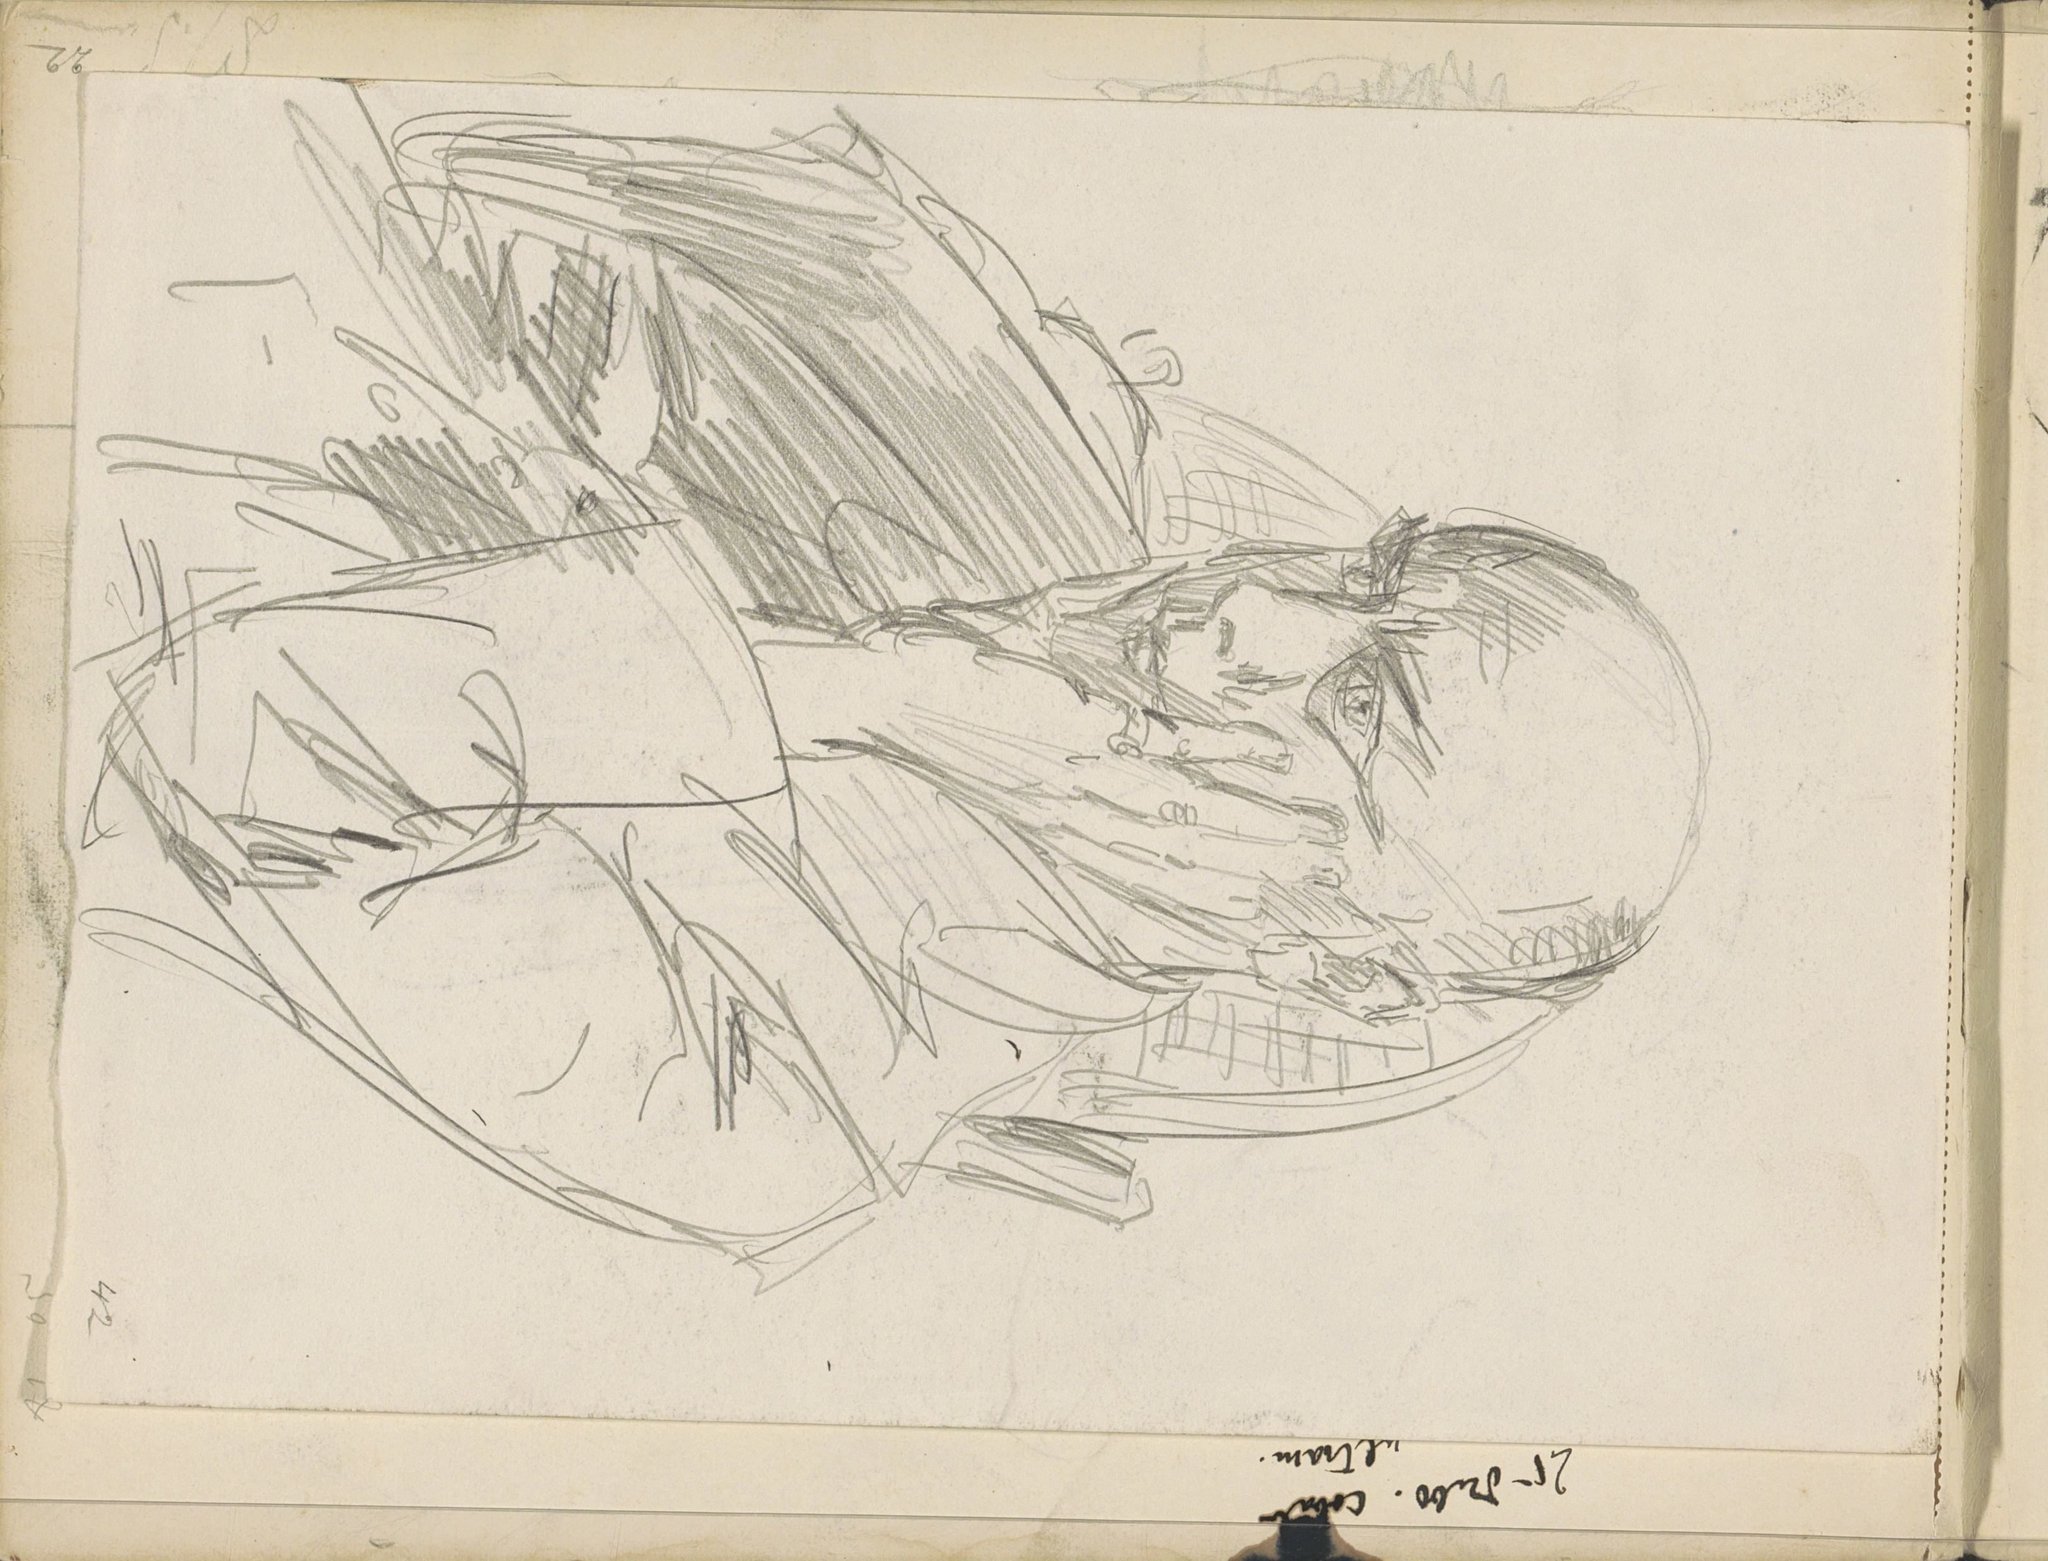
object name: drawing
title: Portret van een onbekende man, zittend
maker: isaac israels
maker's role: draughtsman, painter, print maker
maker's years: 1865-1934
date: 1875-1934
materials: paper, pencil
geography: the hague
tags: adult man (+ sitting), anonymous historical person portrayed, chair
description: Zijn hoofd steunt op zijn hand. Losse tekening, aangetroffen tussen blad 20 verso en het achterste schutblad in schetsboek XXIII met 20 bladen.